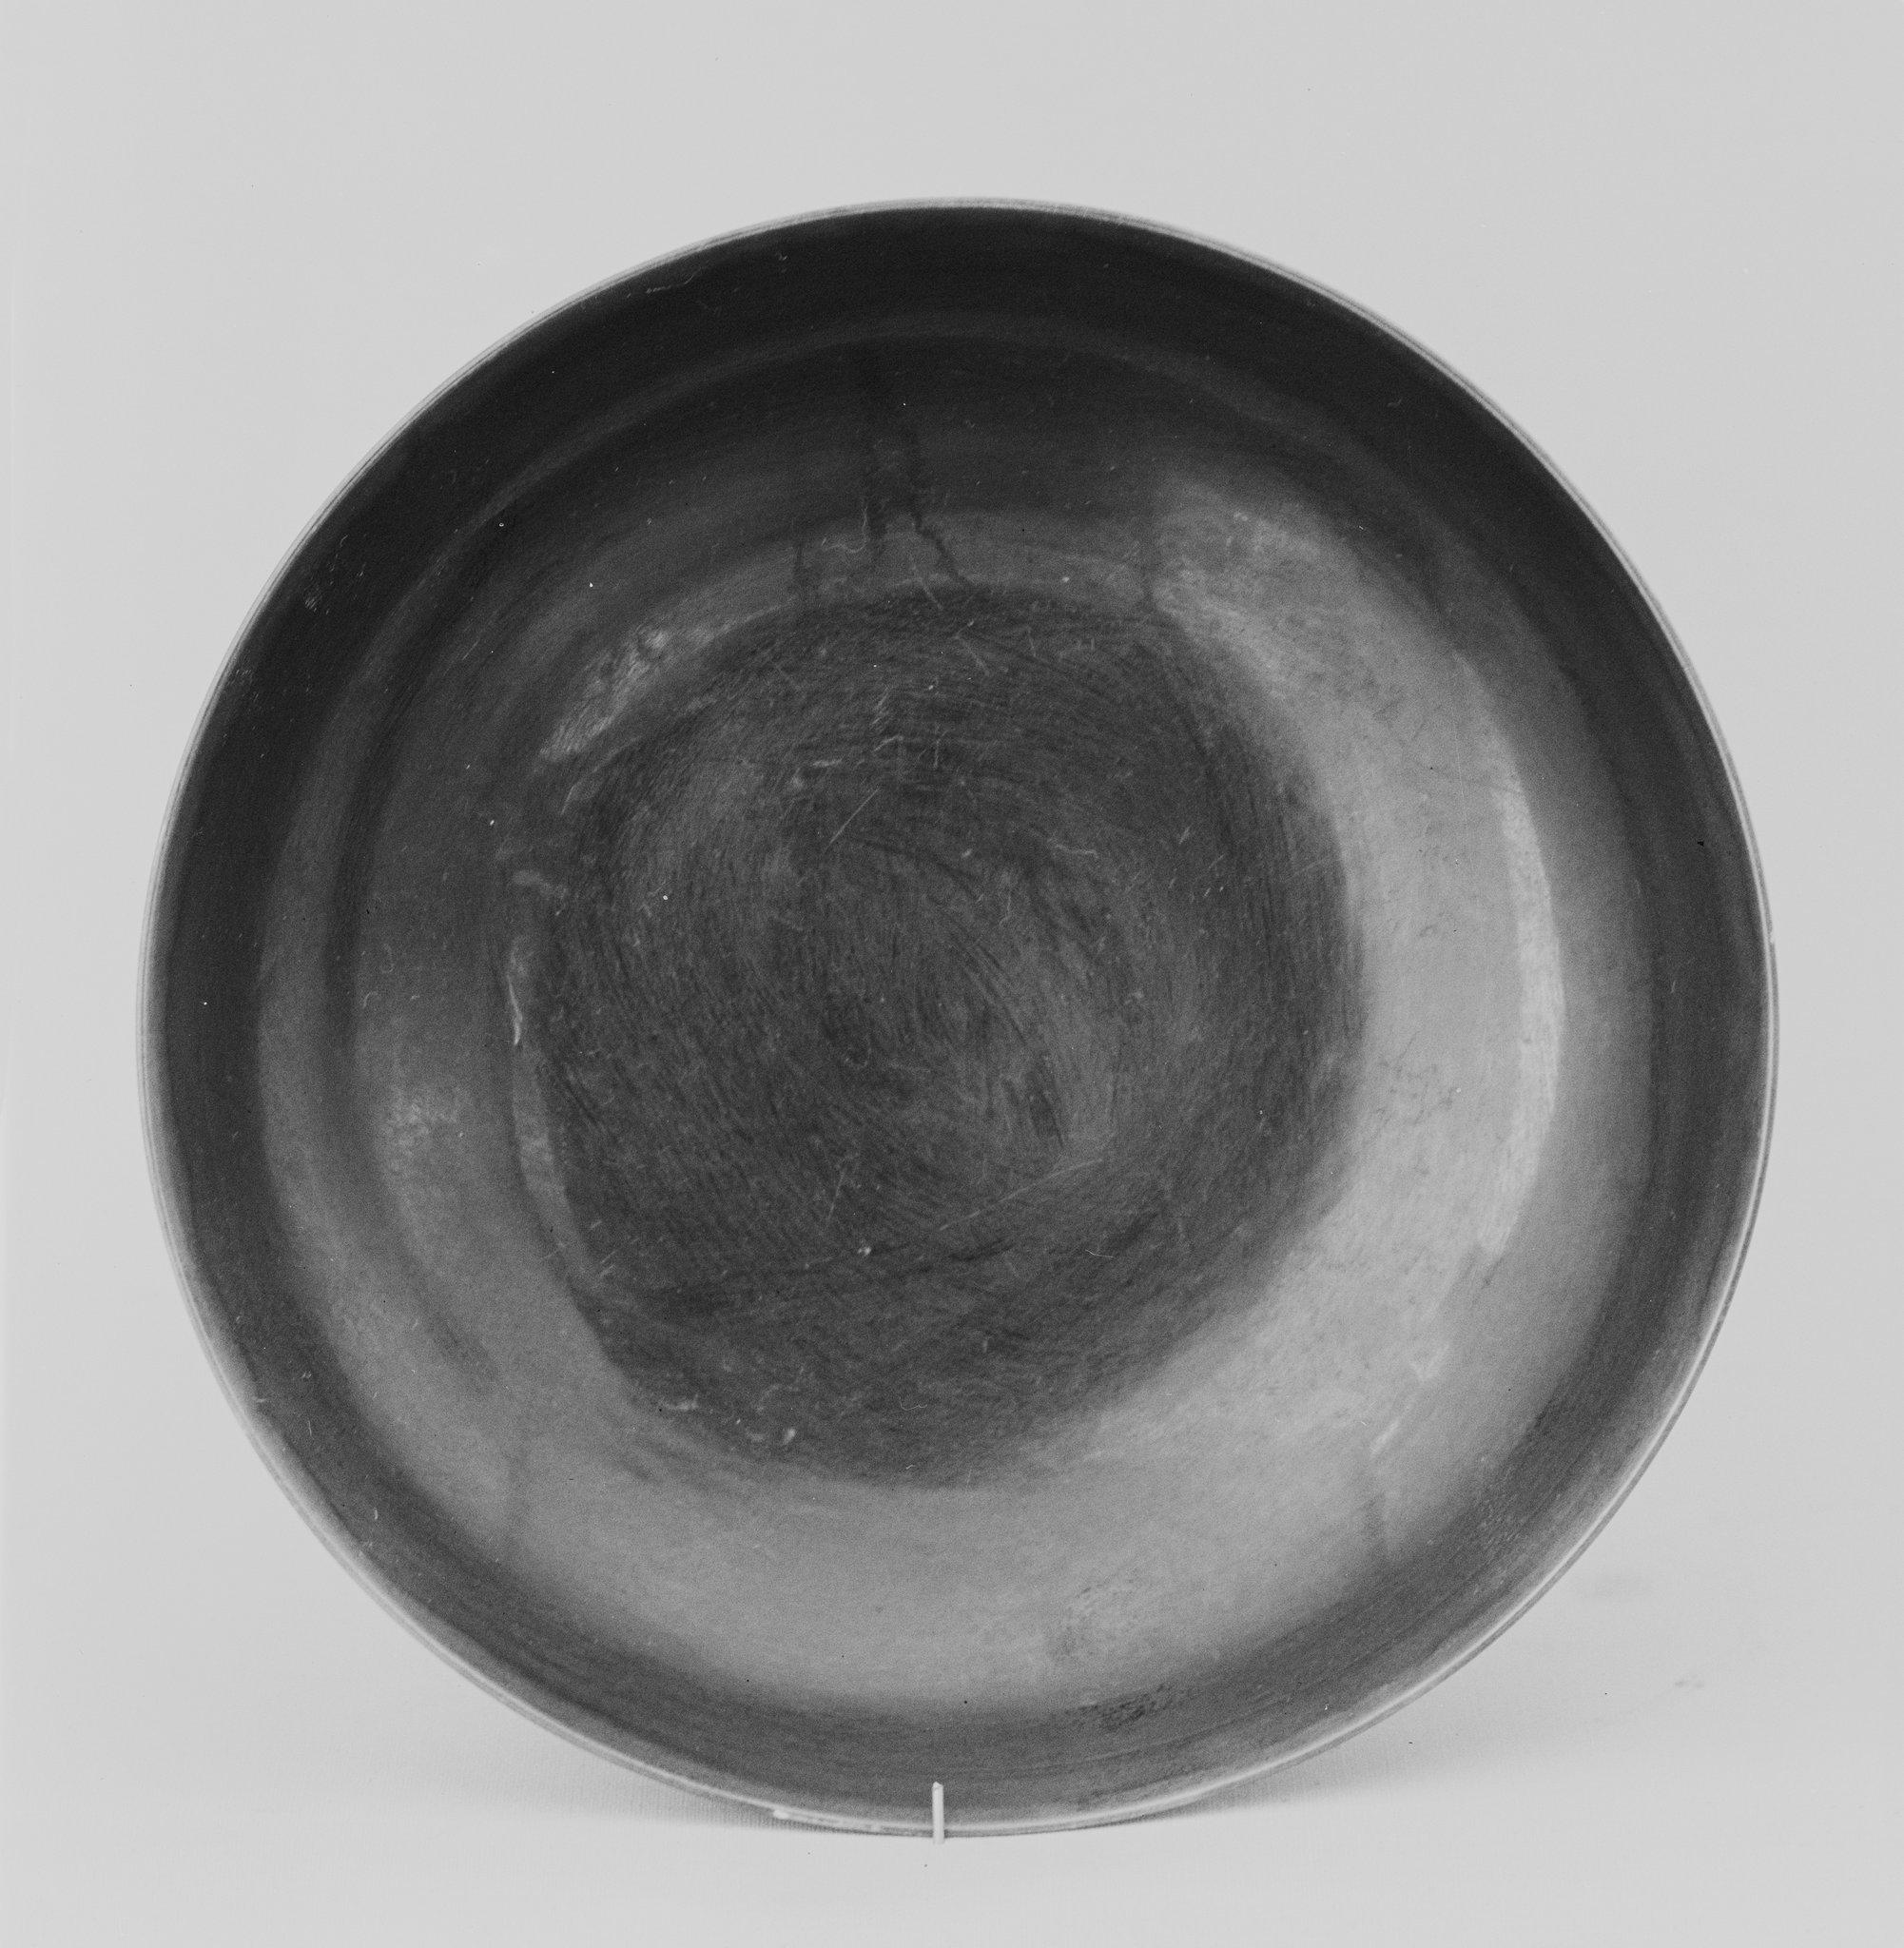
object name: dish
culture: chinese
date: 1723-1735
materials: glaze, porcelain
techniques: incising